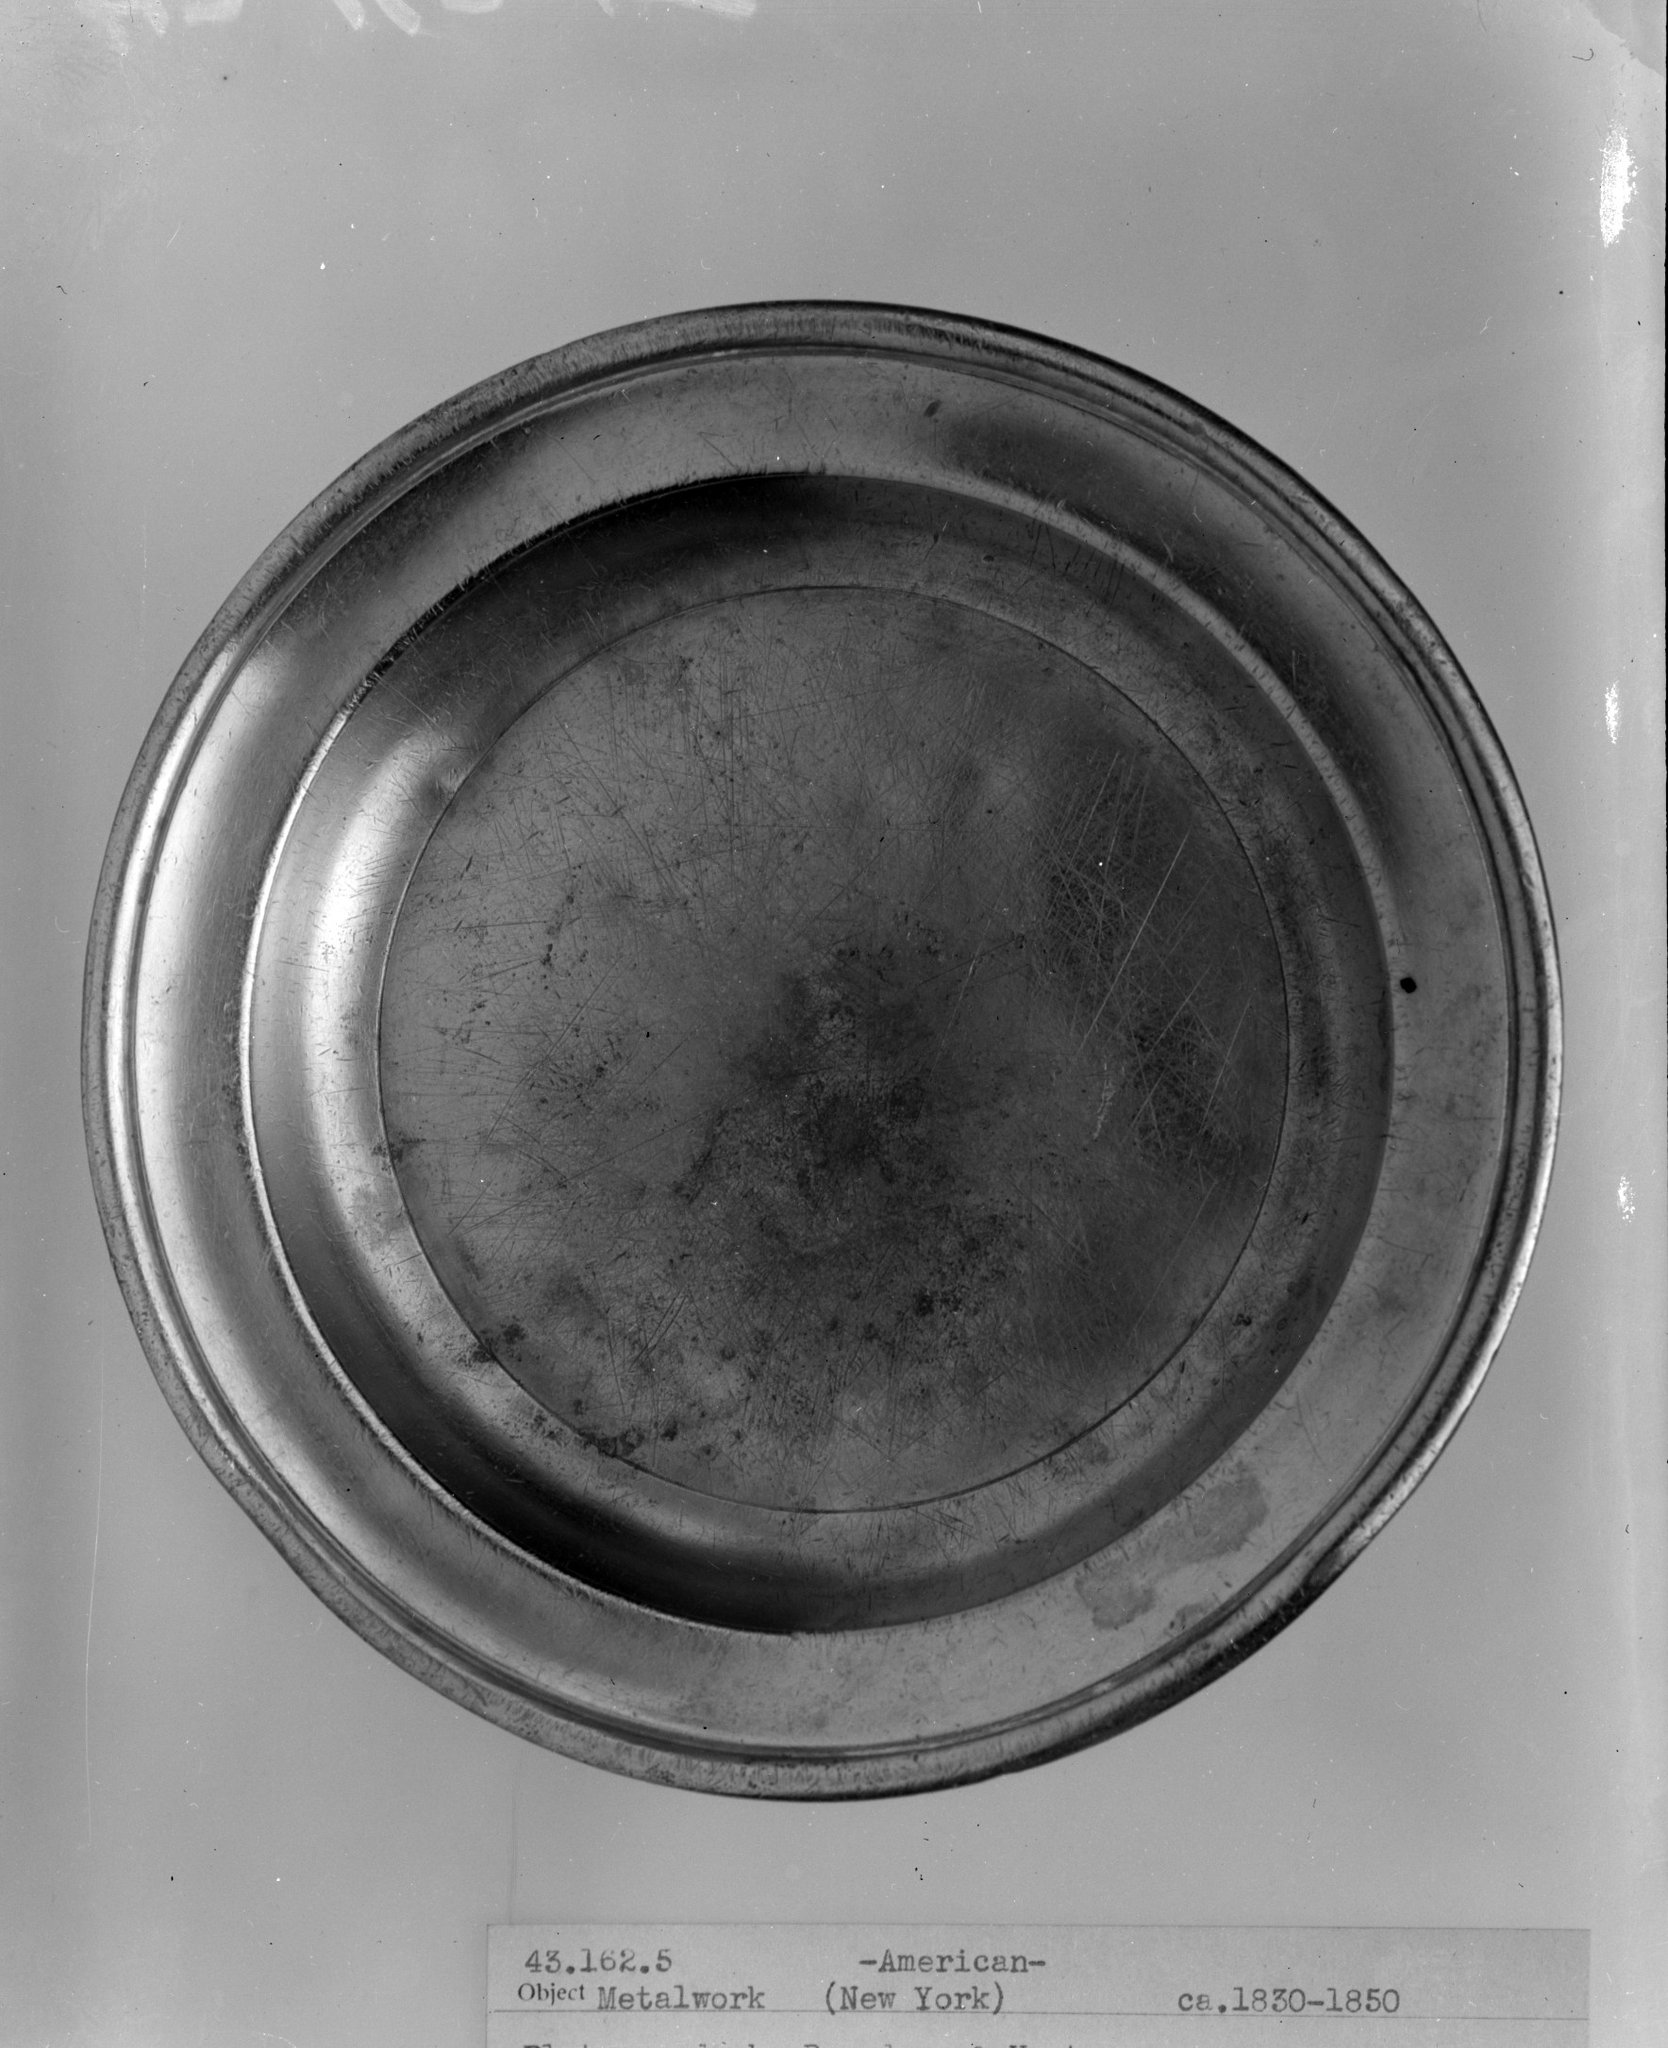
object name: plate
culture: american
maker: thomas danforth boardman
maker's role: maker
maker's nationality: american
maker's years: 1784-1873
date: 1827-1850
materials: pewter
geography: united states